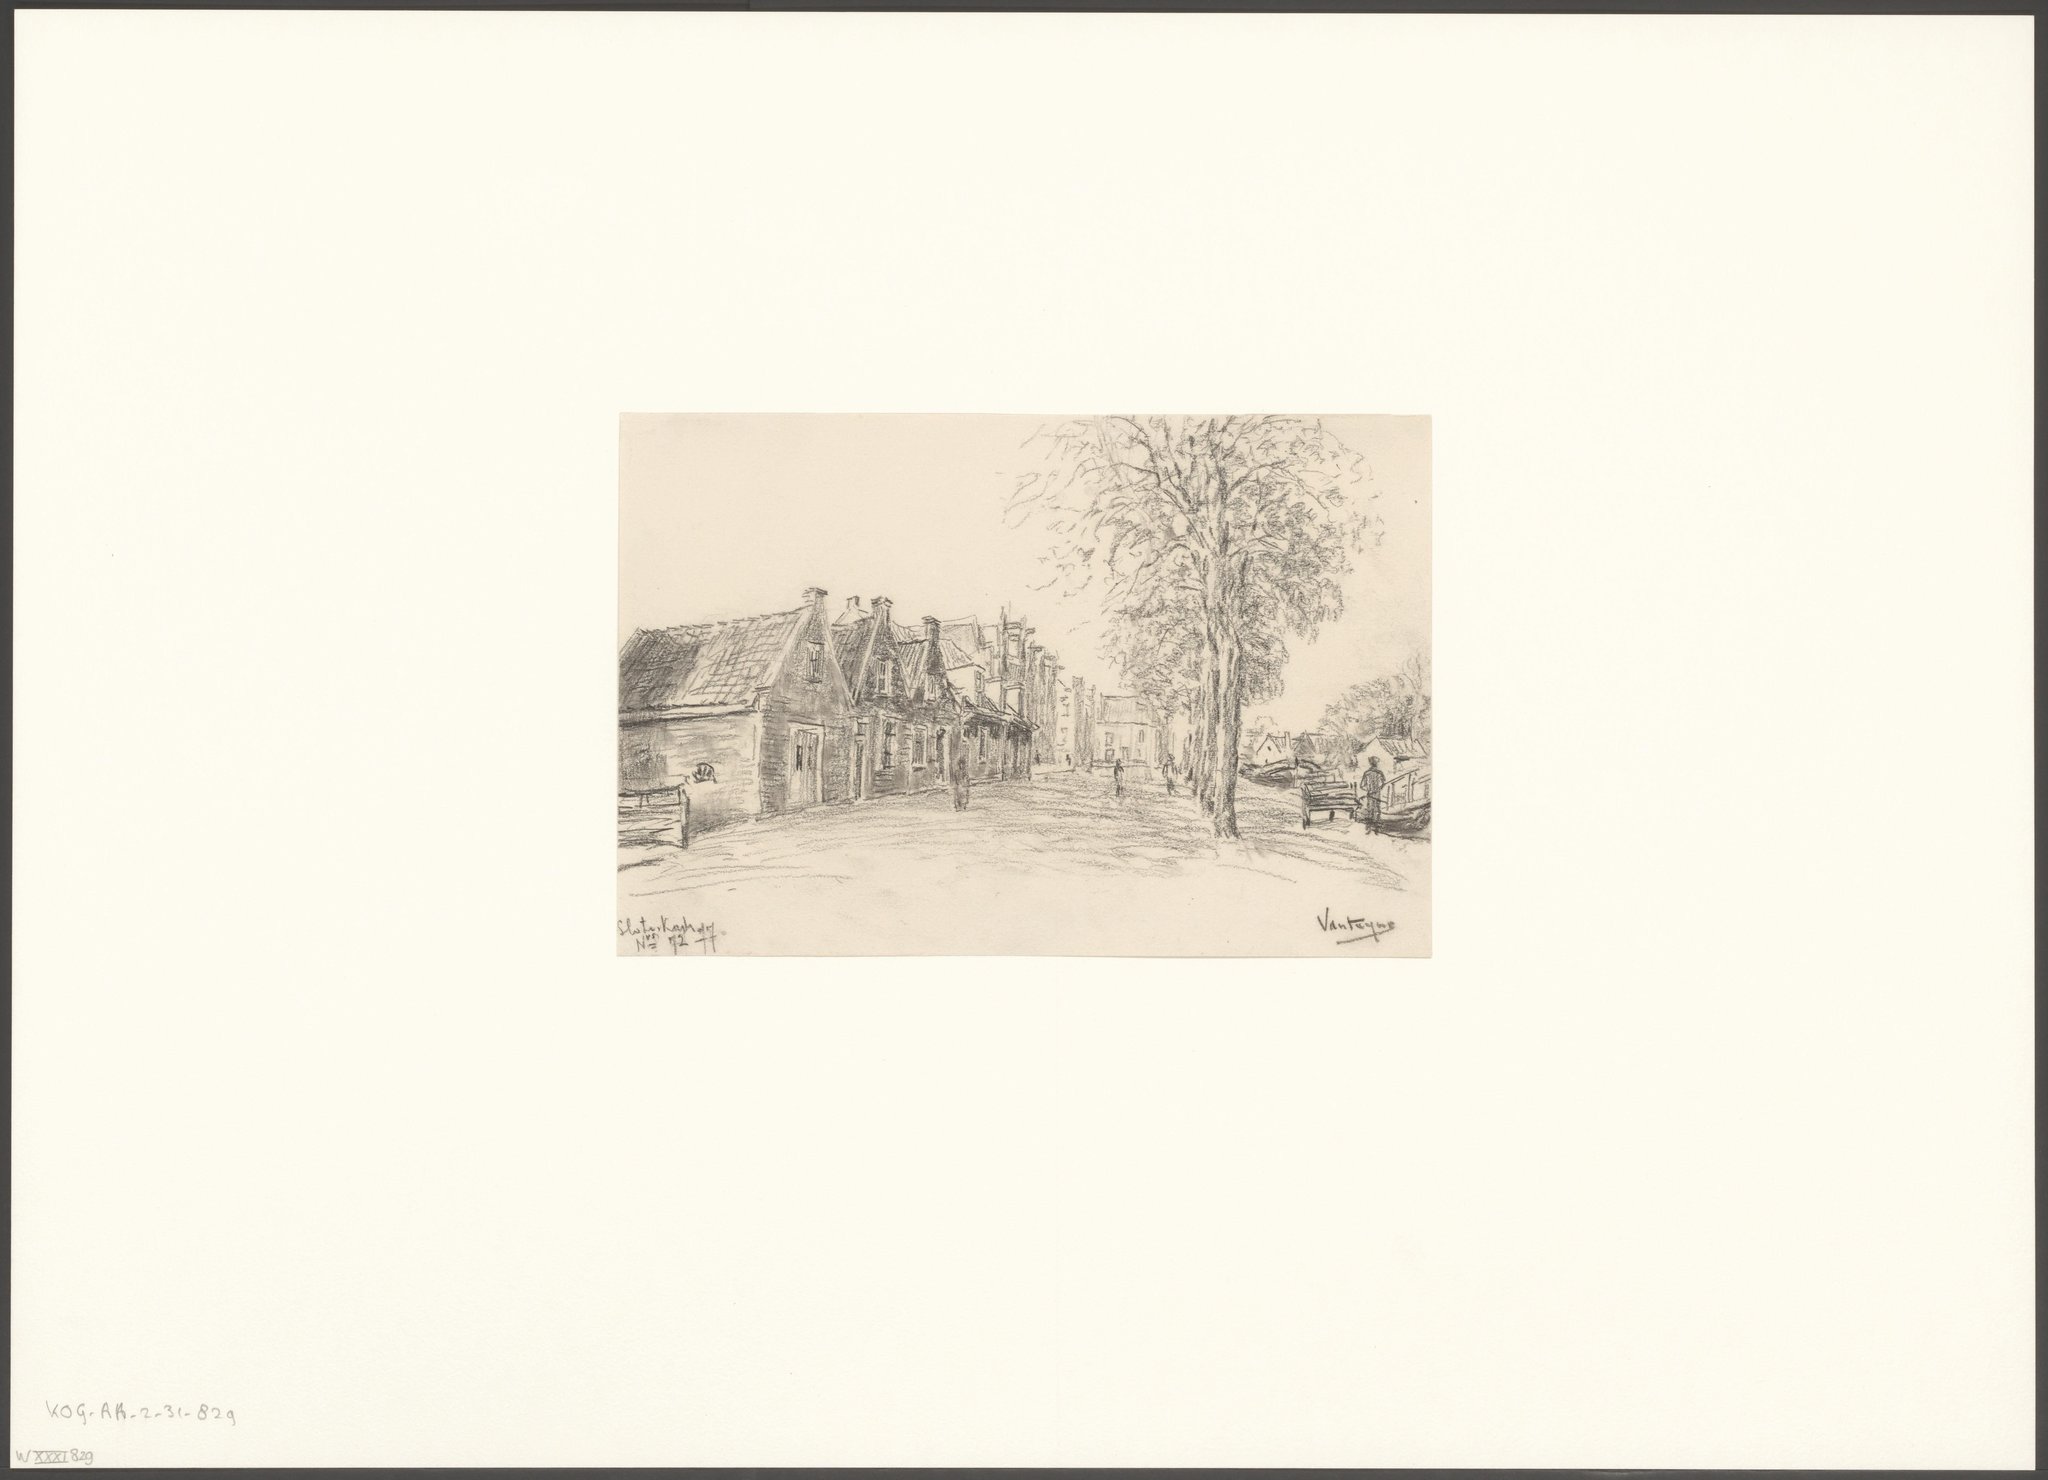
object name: drawing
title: Gezicht op de Sloterkade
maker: anthonie van teijn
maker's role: draughtsman, painter, print maker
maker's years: 1863-1943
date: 1910-1927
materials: chalk, paper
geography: amsterdam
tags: city-view in general; 'veduta', canal, the usual house or row of houses, street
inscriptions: inscription: ‘Sloterkade 72-77 door Ant van Teyn / Oct. 1927 vanEck’, inscription: ‘Sloterkade / Nrs 72 77’, collector's mark: Lugt 800a, signature: ‘VanTeyne’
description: Tekening binnen de Atlas Van Eck ingedeeld op wijknummer 31.